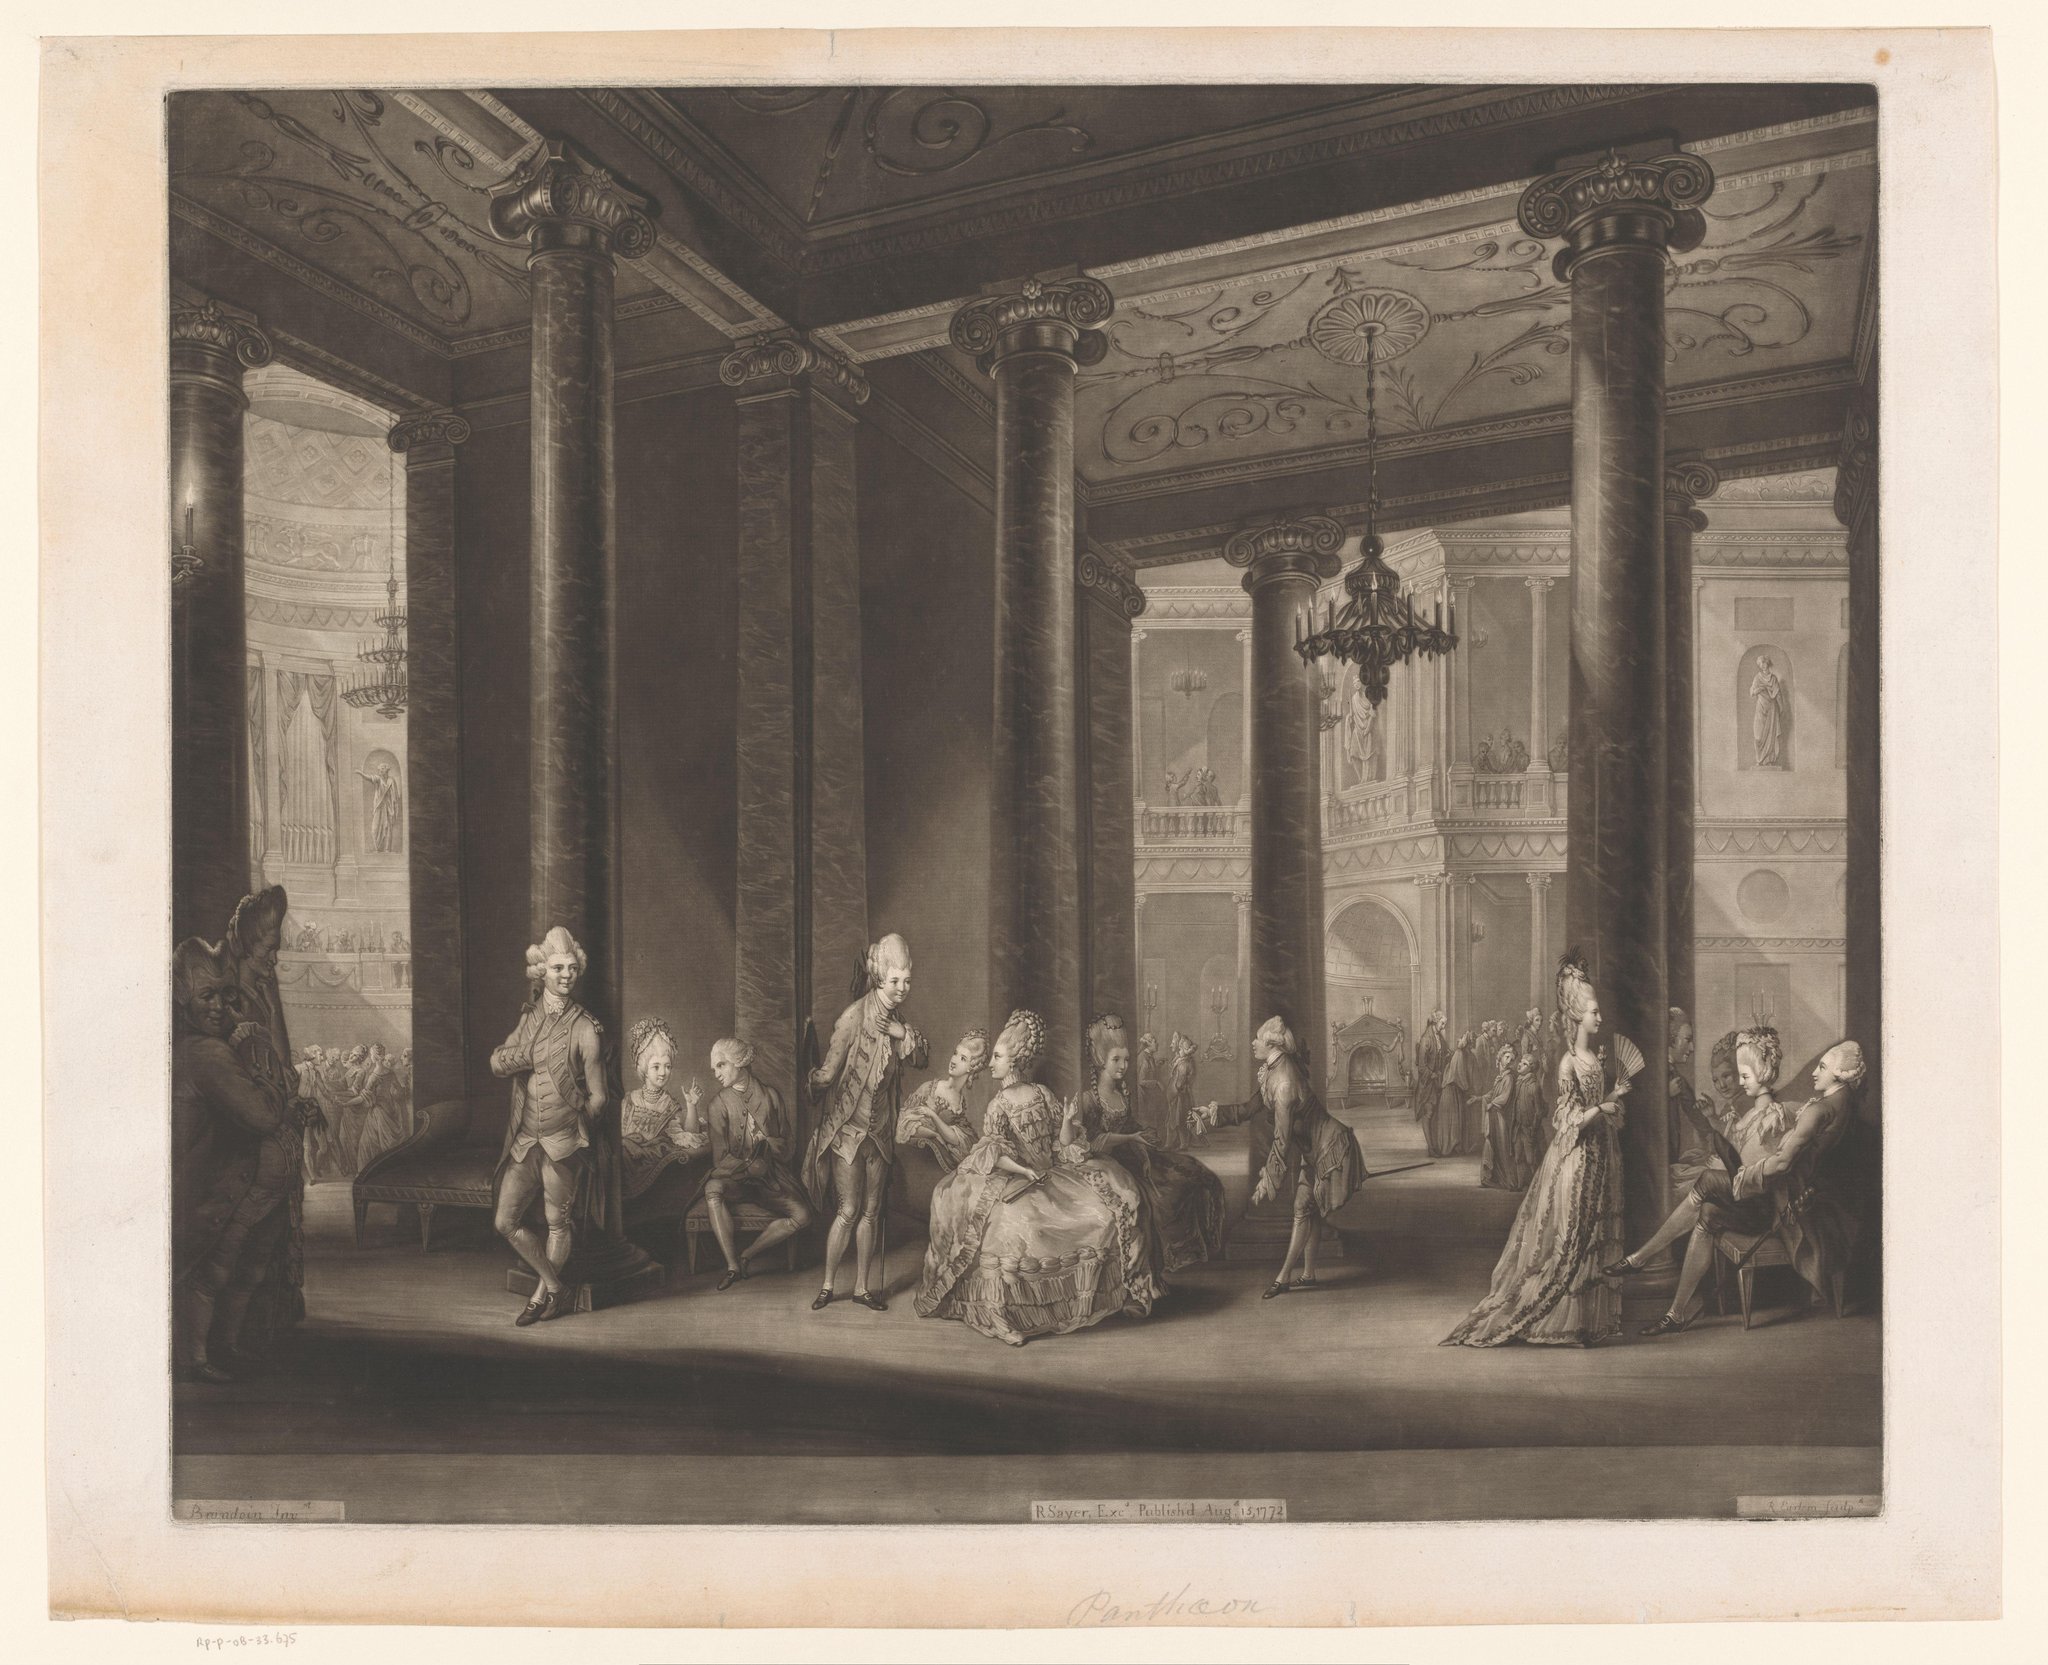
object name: print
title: Interieur van het Pantheon op Oxford Street in Londen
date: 1708-1772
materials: paper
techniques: mezzotint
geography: london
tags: dancing, visiting; receiving guests; elegant company, fan, conversation, dialogue; conversation piece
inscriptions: date